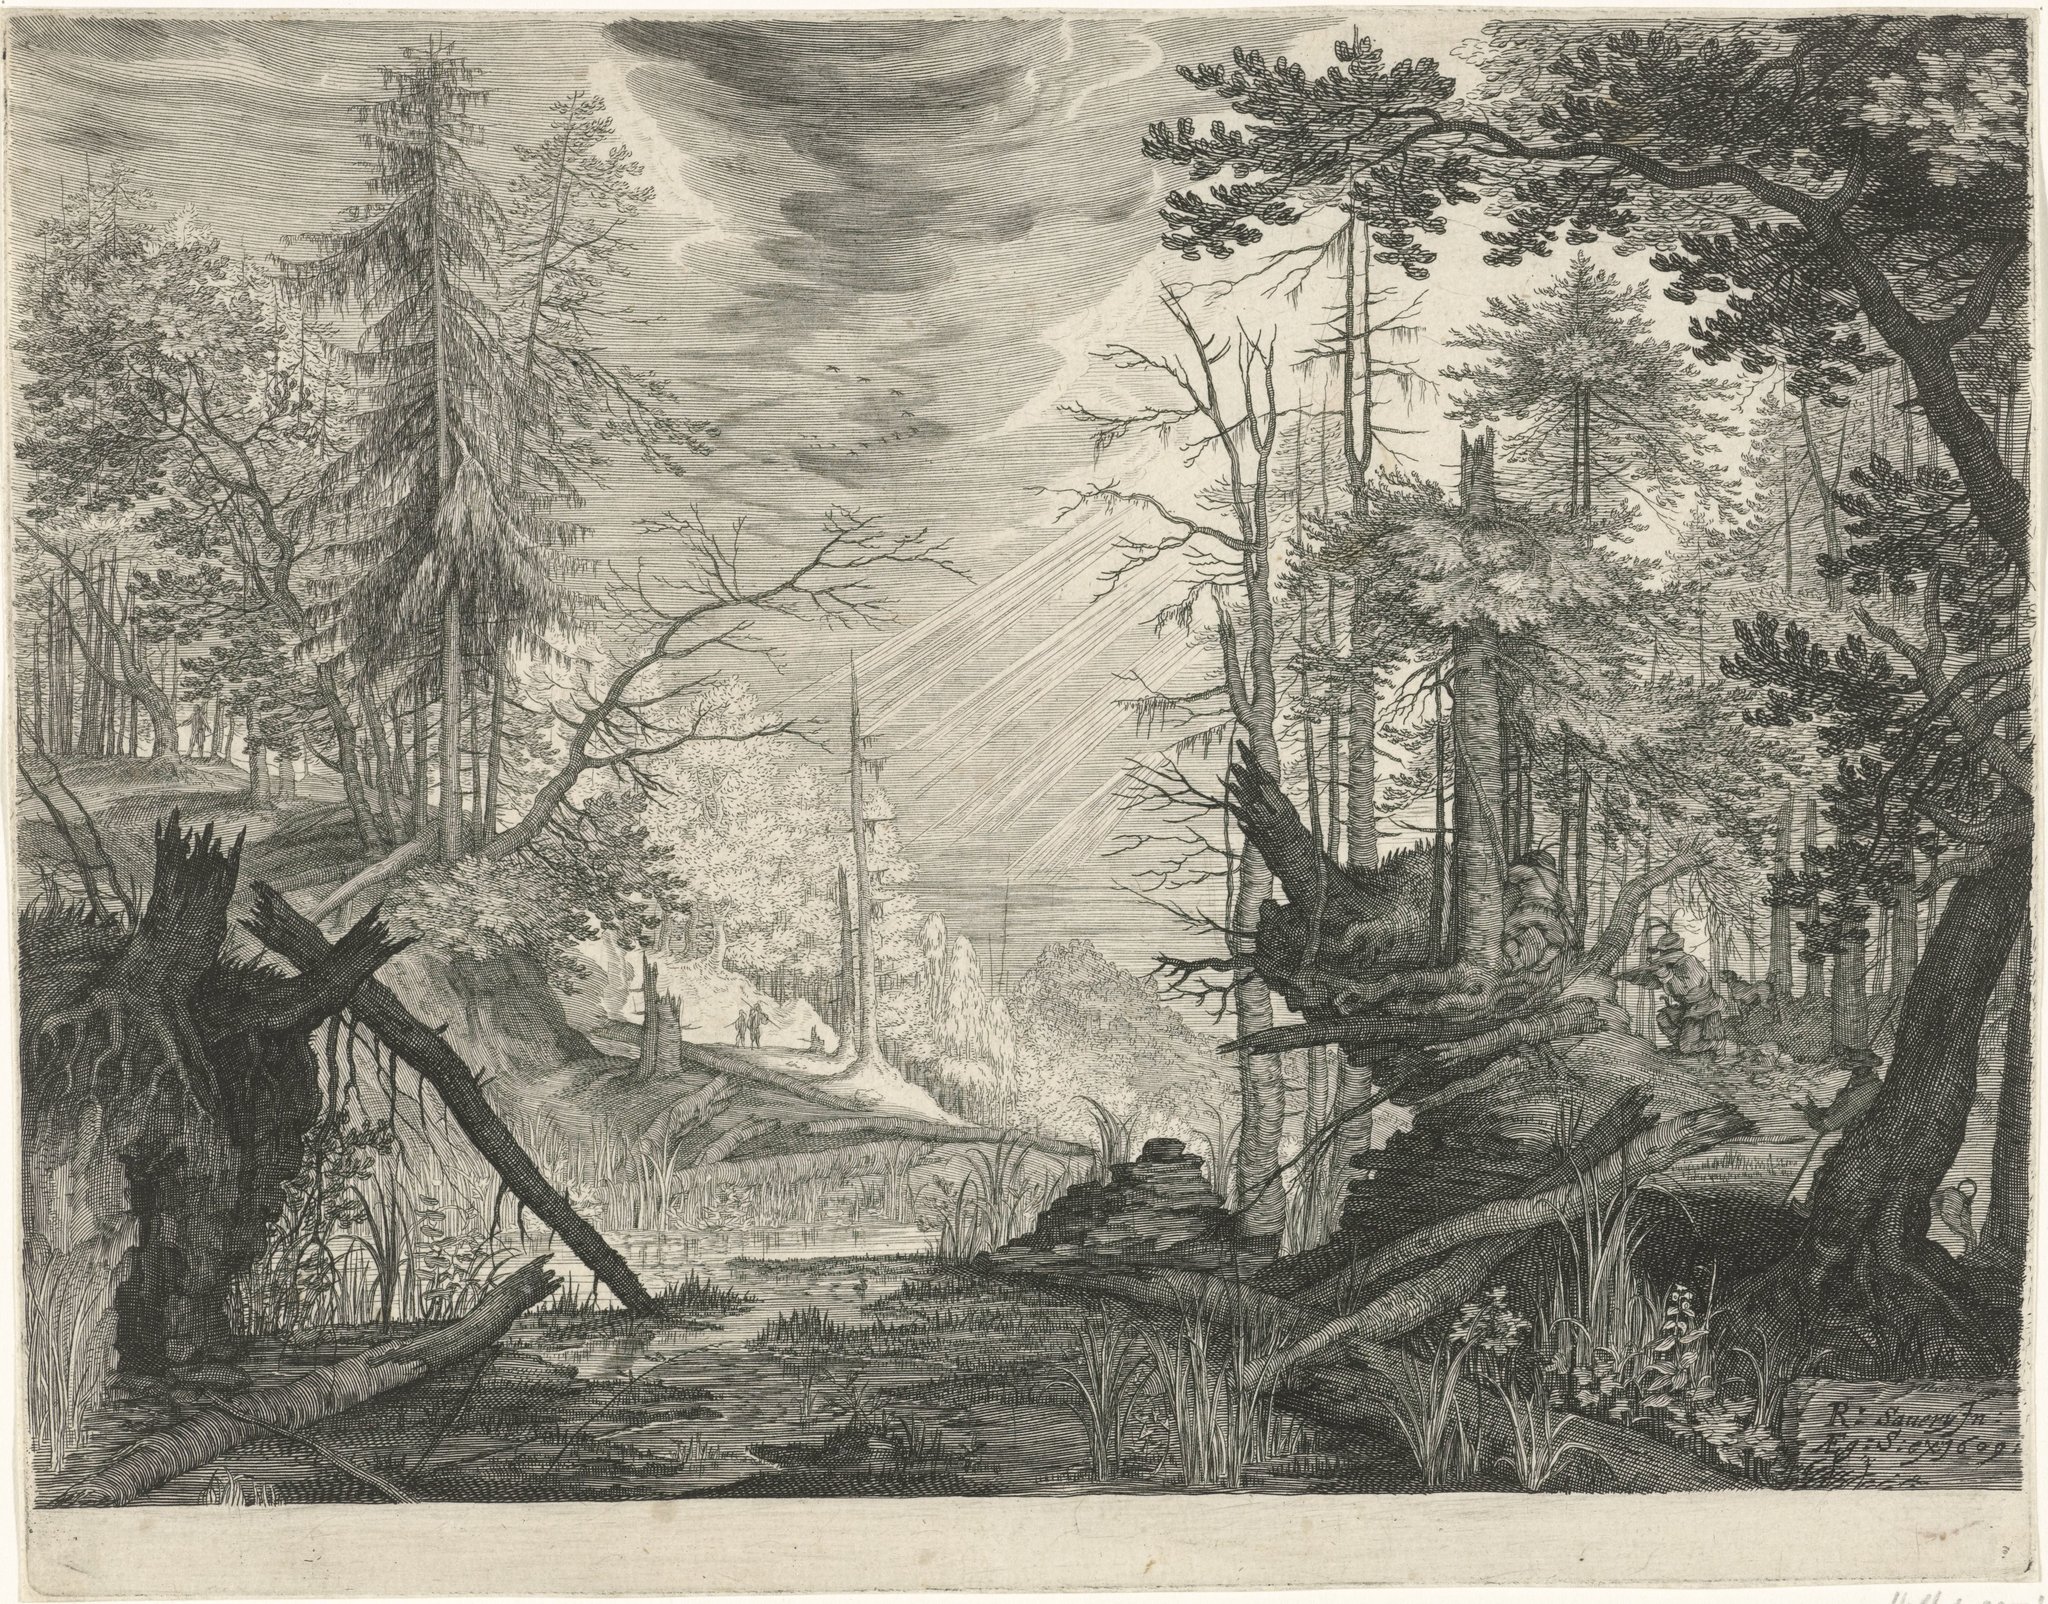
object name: print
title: Drie jagers bij een rivier in een bos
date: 1609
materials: paper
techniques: engraving, etching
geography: prague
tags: hunting dogs, hunter, forest, wood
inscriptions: collector's mark: Lugt 240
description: Boslandschap met omgevallen dode bomen bij een rivier. Rechts aan de oever drie jagers en een hond. Eerste prent van een zesdelige reeks met berglandschappen uit Tirol.